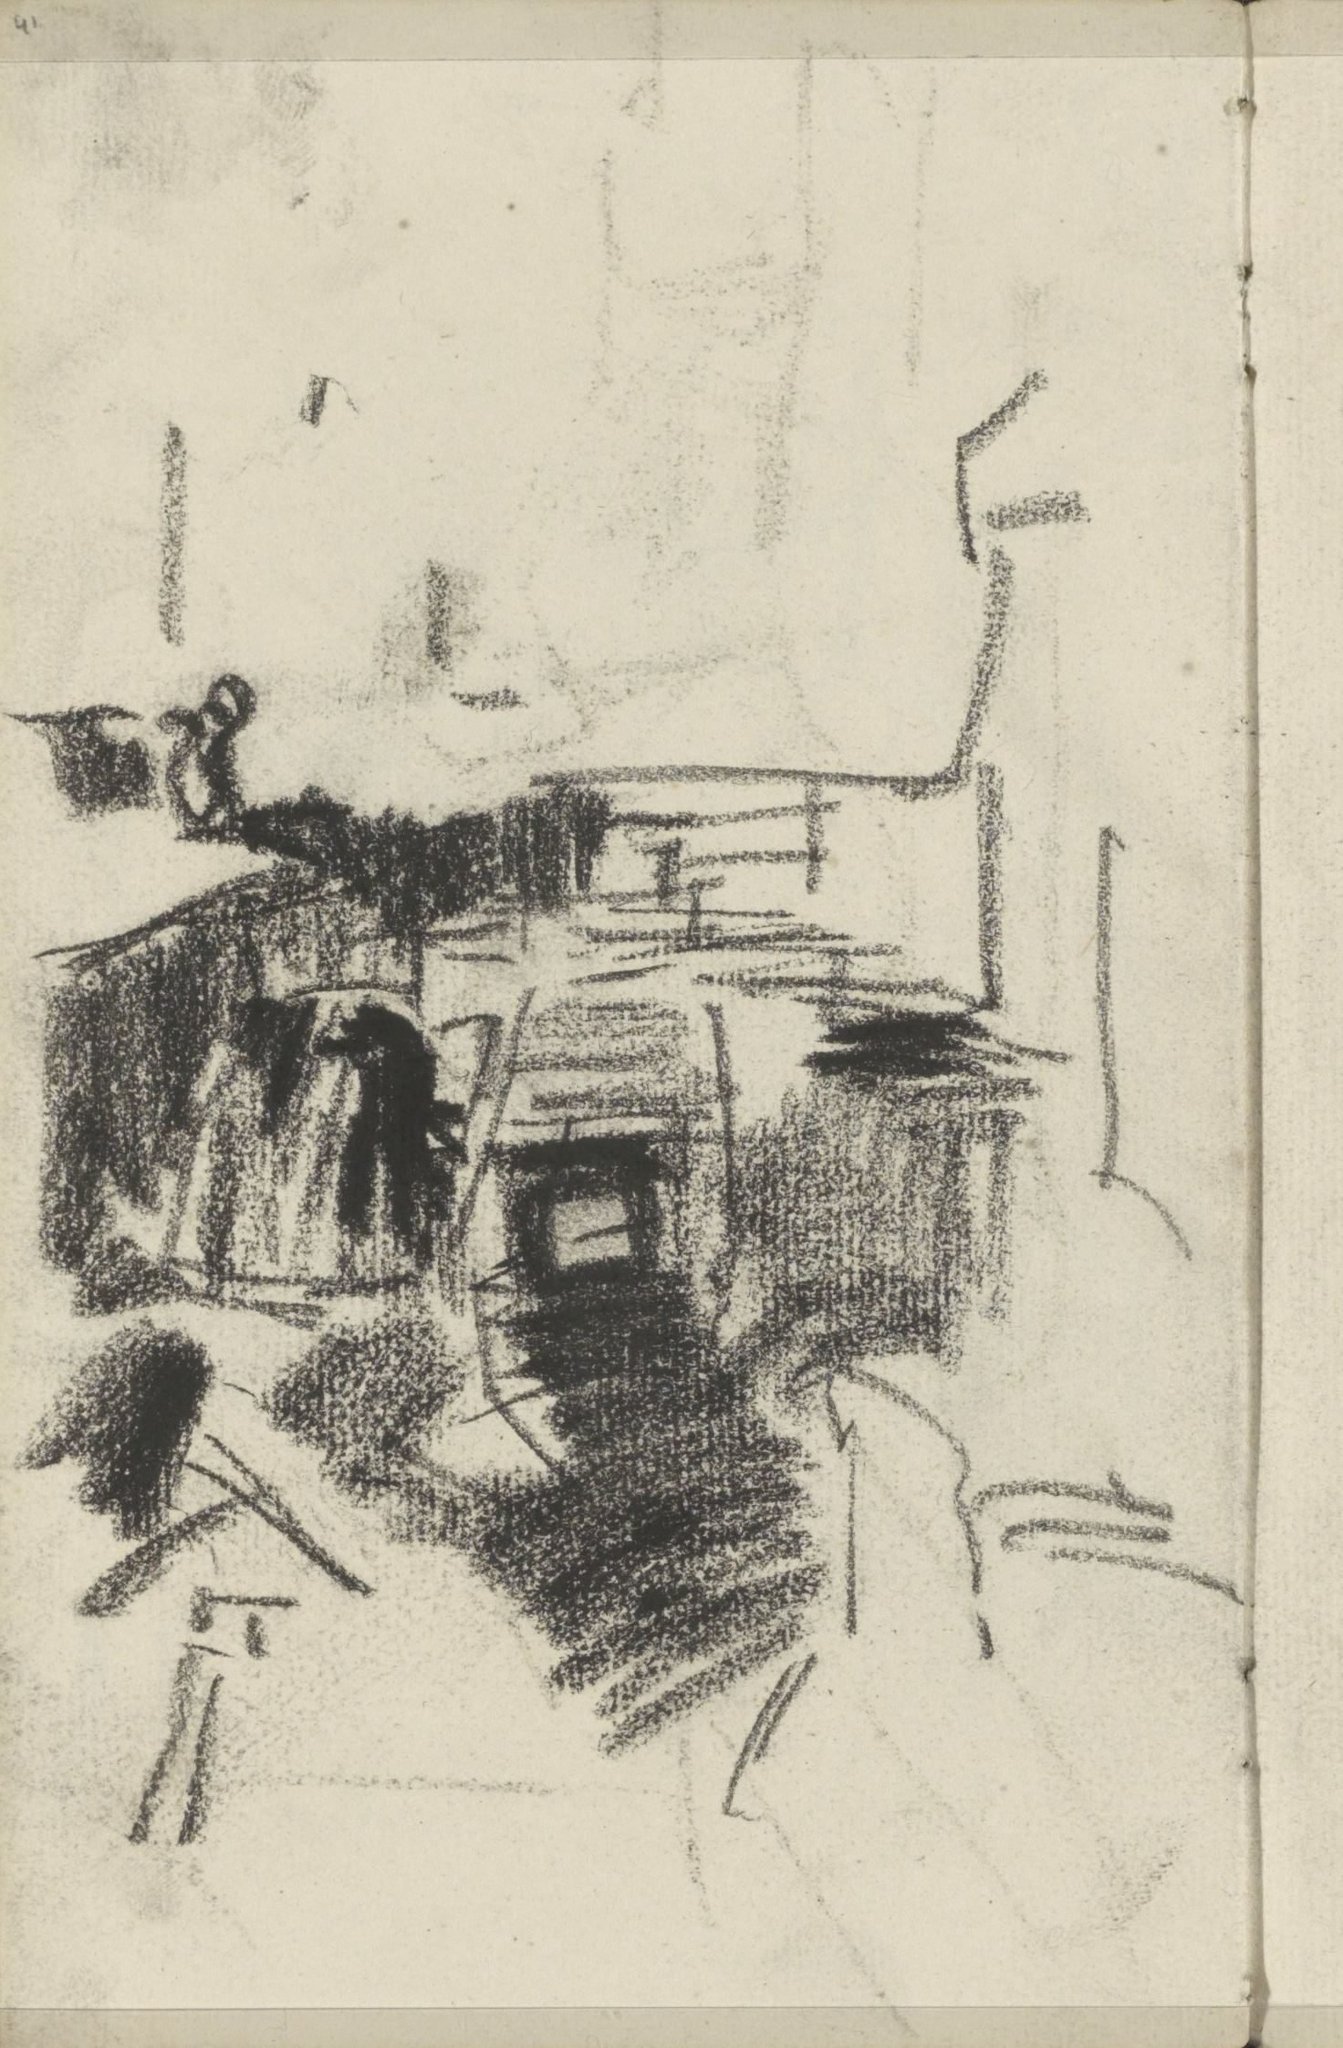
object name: sketchbook leaf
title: Studie, mogelijk van boten in het water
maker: george hendrik breitner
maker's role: draughtsman, painter, print maker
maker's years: 1857-1923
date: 1884-1886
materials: chalk, paper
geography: the hague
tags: ships (in general), canals, waters (in city) (+ city(-scape) with figures, staffage)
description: Pagina 41 uit een schetsboek met 29 bladen.